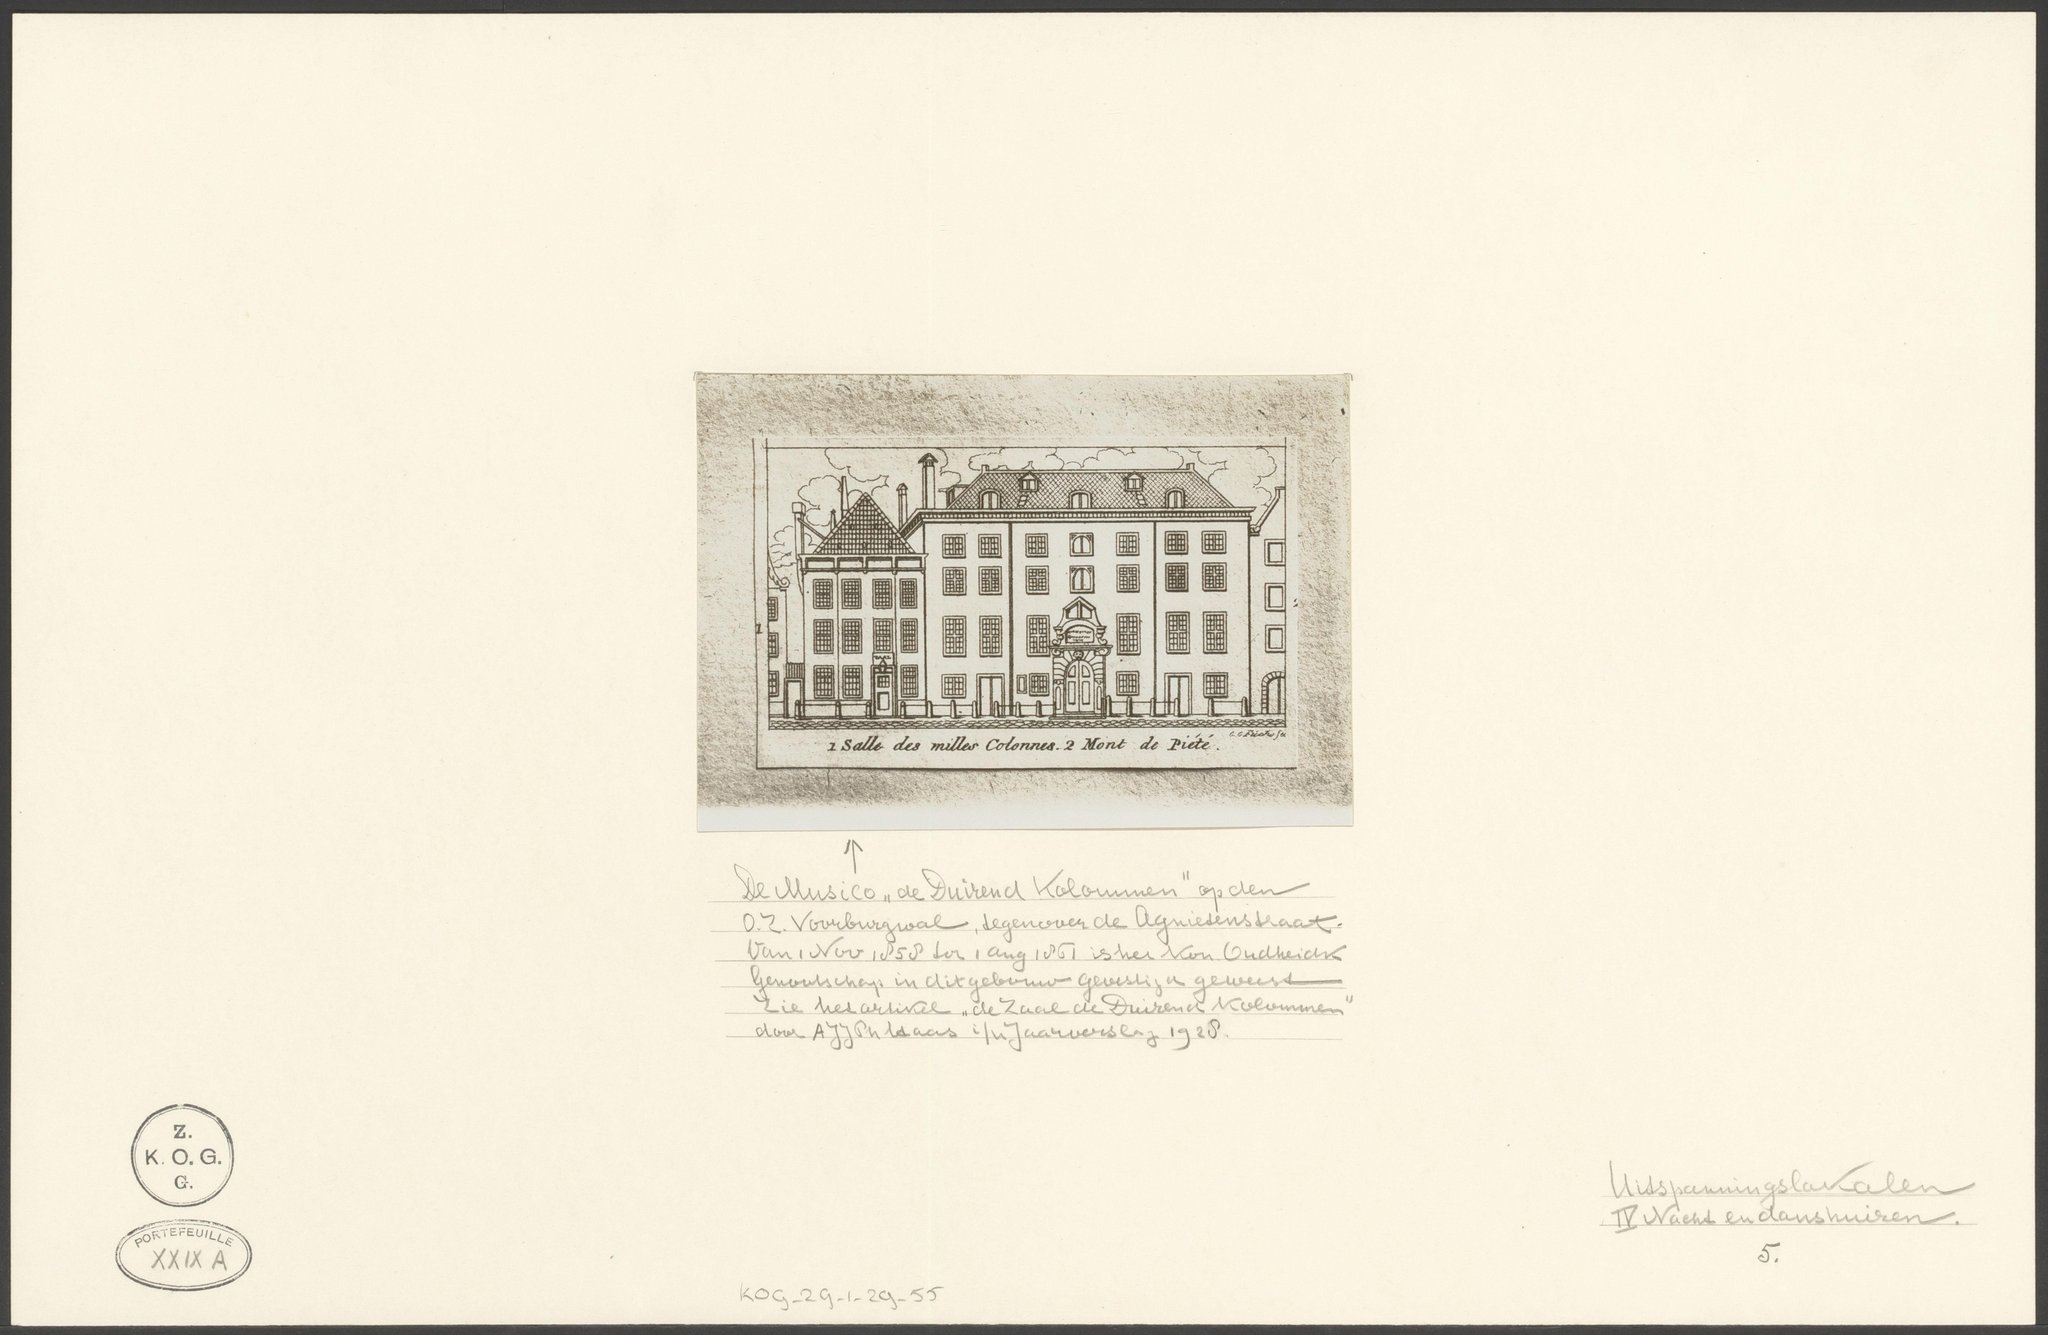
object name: photograph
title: Gezicht op theater De Duizend Kolommen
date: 1928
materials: photographic support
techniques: gelatin silver print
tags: front façade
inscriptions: stamp, collector's mark: Lugt 1641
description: Gezicht op theater De Duizend Kolommen. Van 1 november 1858 tot 1 augustus 1861 was het Koninklijk Oudheidkundig Genootschp in dit gebouw gevestigd. Onderwerpsrubrieken binnen de Atlas Zeden en Gewoonten: Zeden en gewoonten in engeren zin, Volksleven, Uitspanningslokalen, Nacht- en danshuizen.